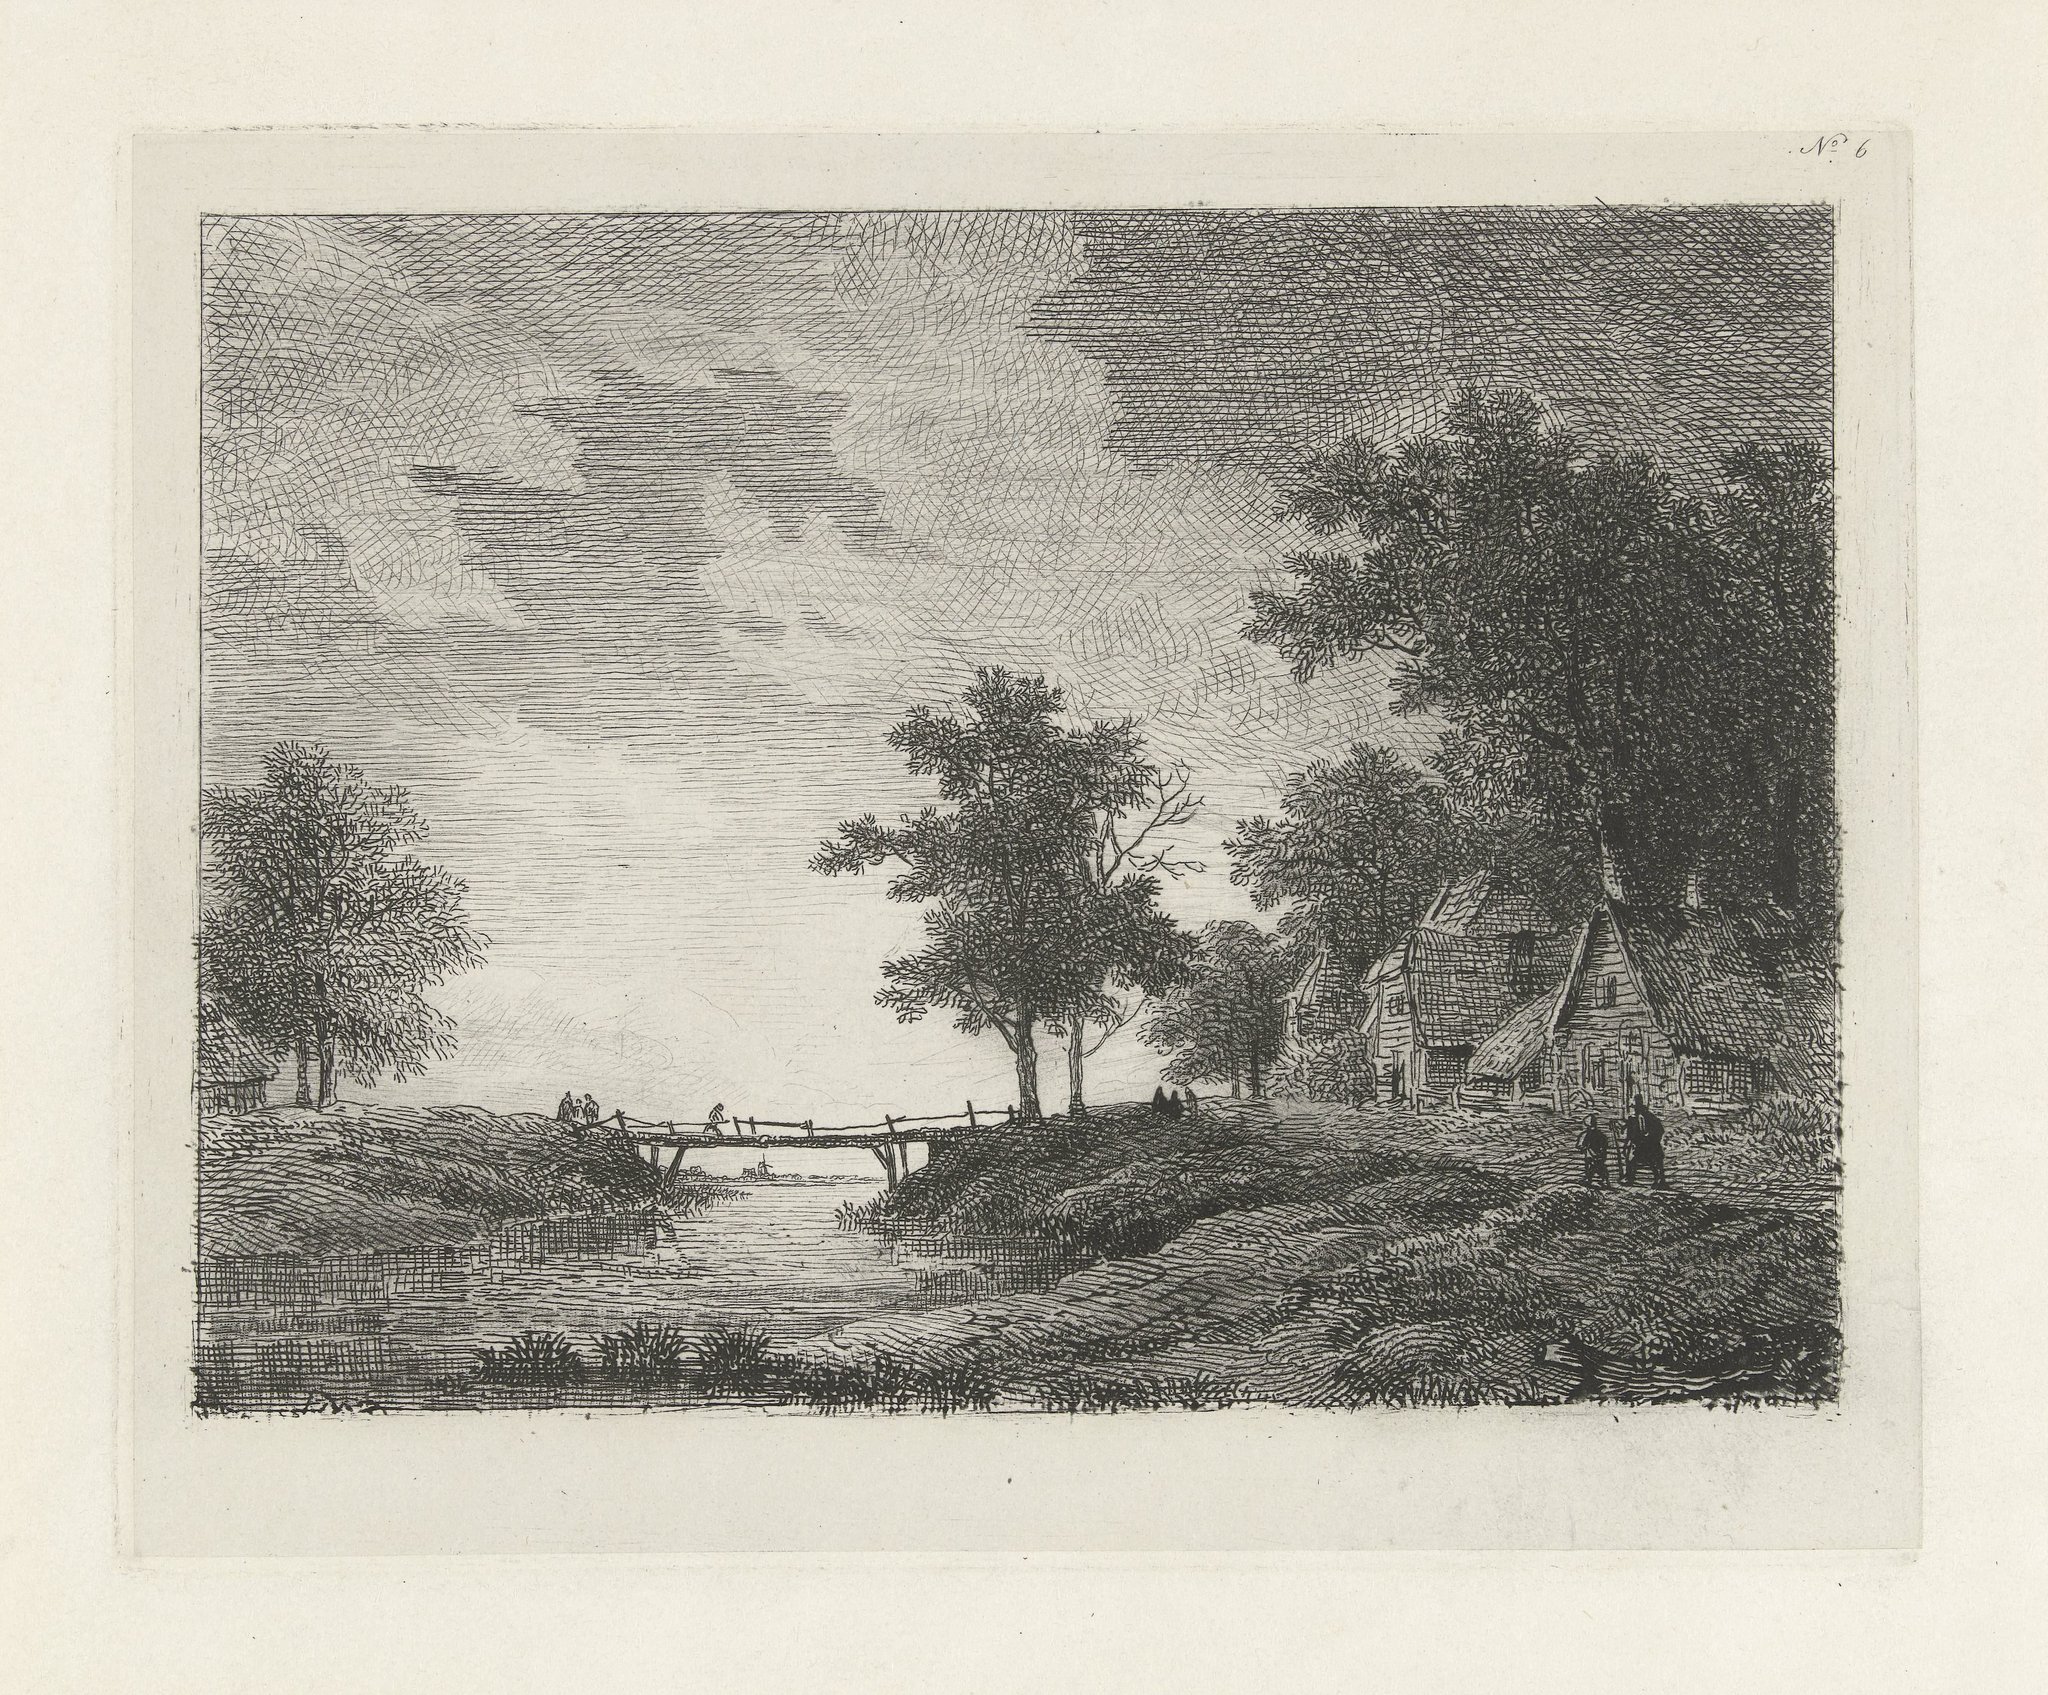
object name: print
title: Landschap met figuren bij een brug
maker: remigius adrianus haanen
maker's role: draughtsman, painter, print maker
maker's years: 1812-1894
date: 1849-1888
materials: paper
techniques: etching, roulette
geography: austria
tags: landscape with bridge, viaduct or aqueduct (+ city(-scape) with figures, staffage)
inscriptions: collector's mark: Lugt 2228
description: Deze prent is genummerd No.6 rechtsboven en zou om die reden een prent kunnen zijn uit de serie van zes waarvan het titelblad is beschreven onder RP-P-OB-55.650.